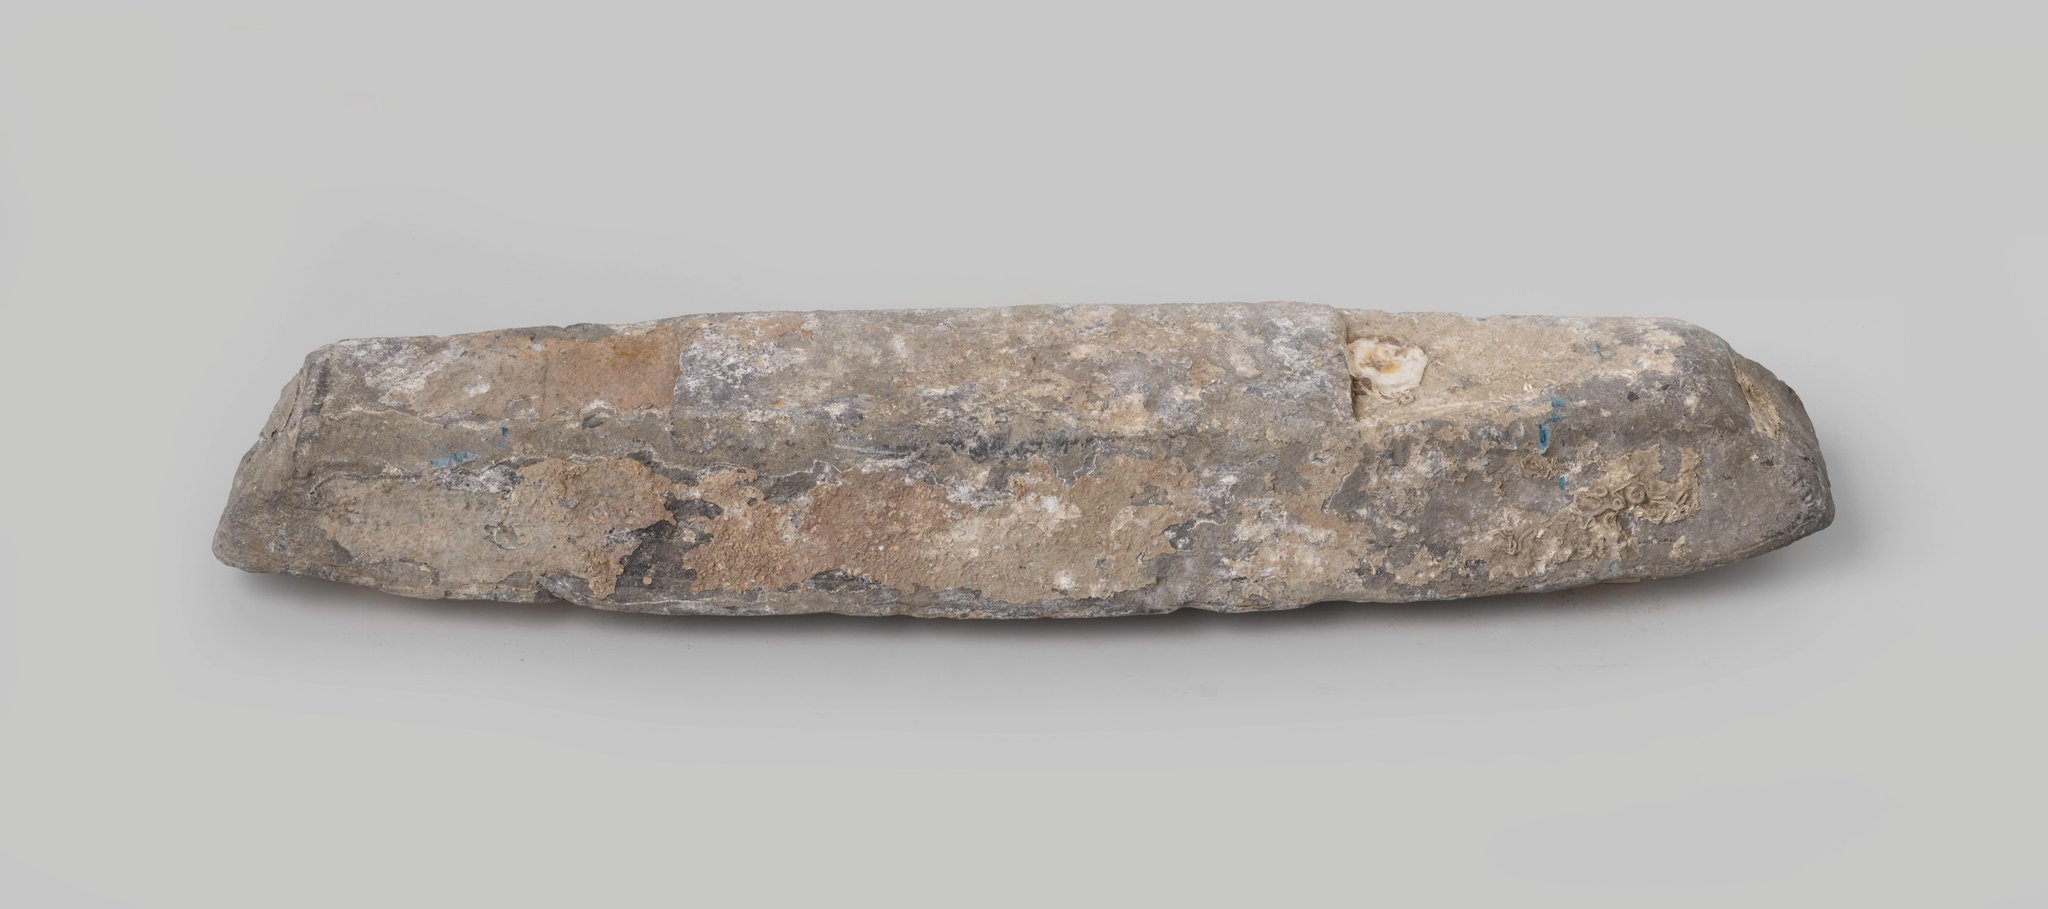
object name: ingot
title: Ballastlood uit het wrak van de Oost-Indiëvaarder Hollandia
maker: Anonymous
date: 1700-1743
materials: lead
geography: netherlands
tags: verenigde oostindische compagnie, hollandia (schip), annet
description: Ingot; corroded, sim. NG 1979-265H, central part of underside raised, marks visible [C, others illegible].